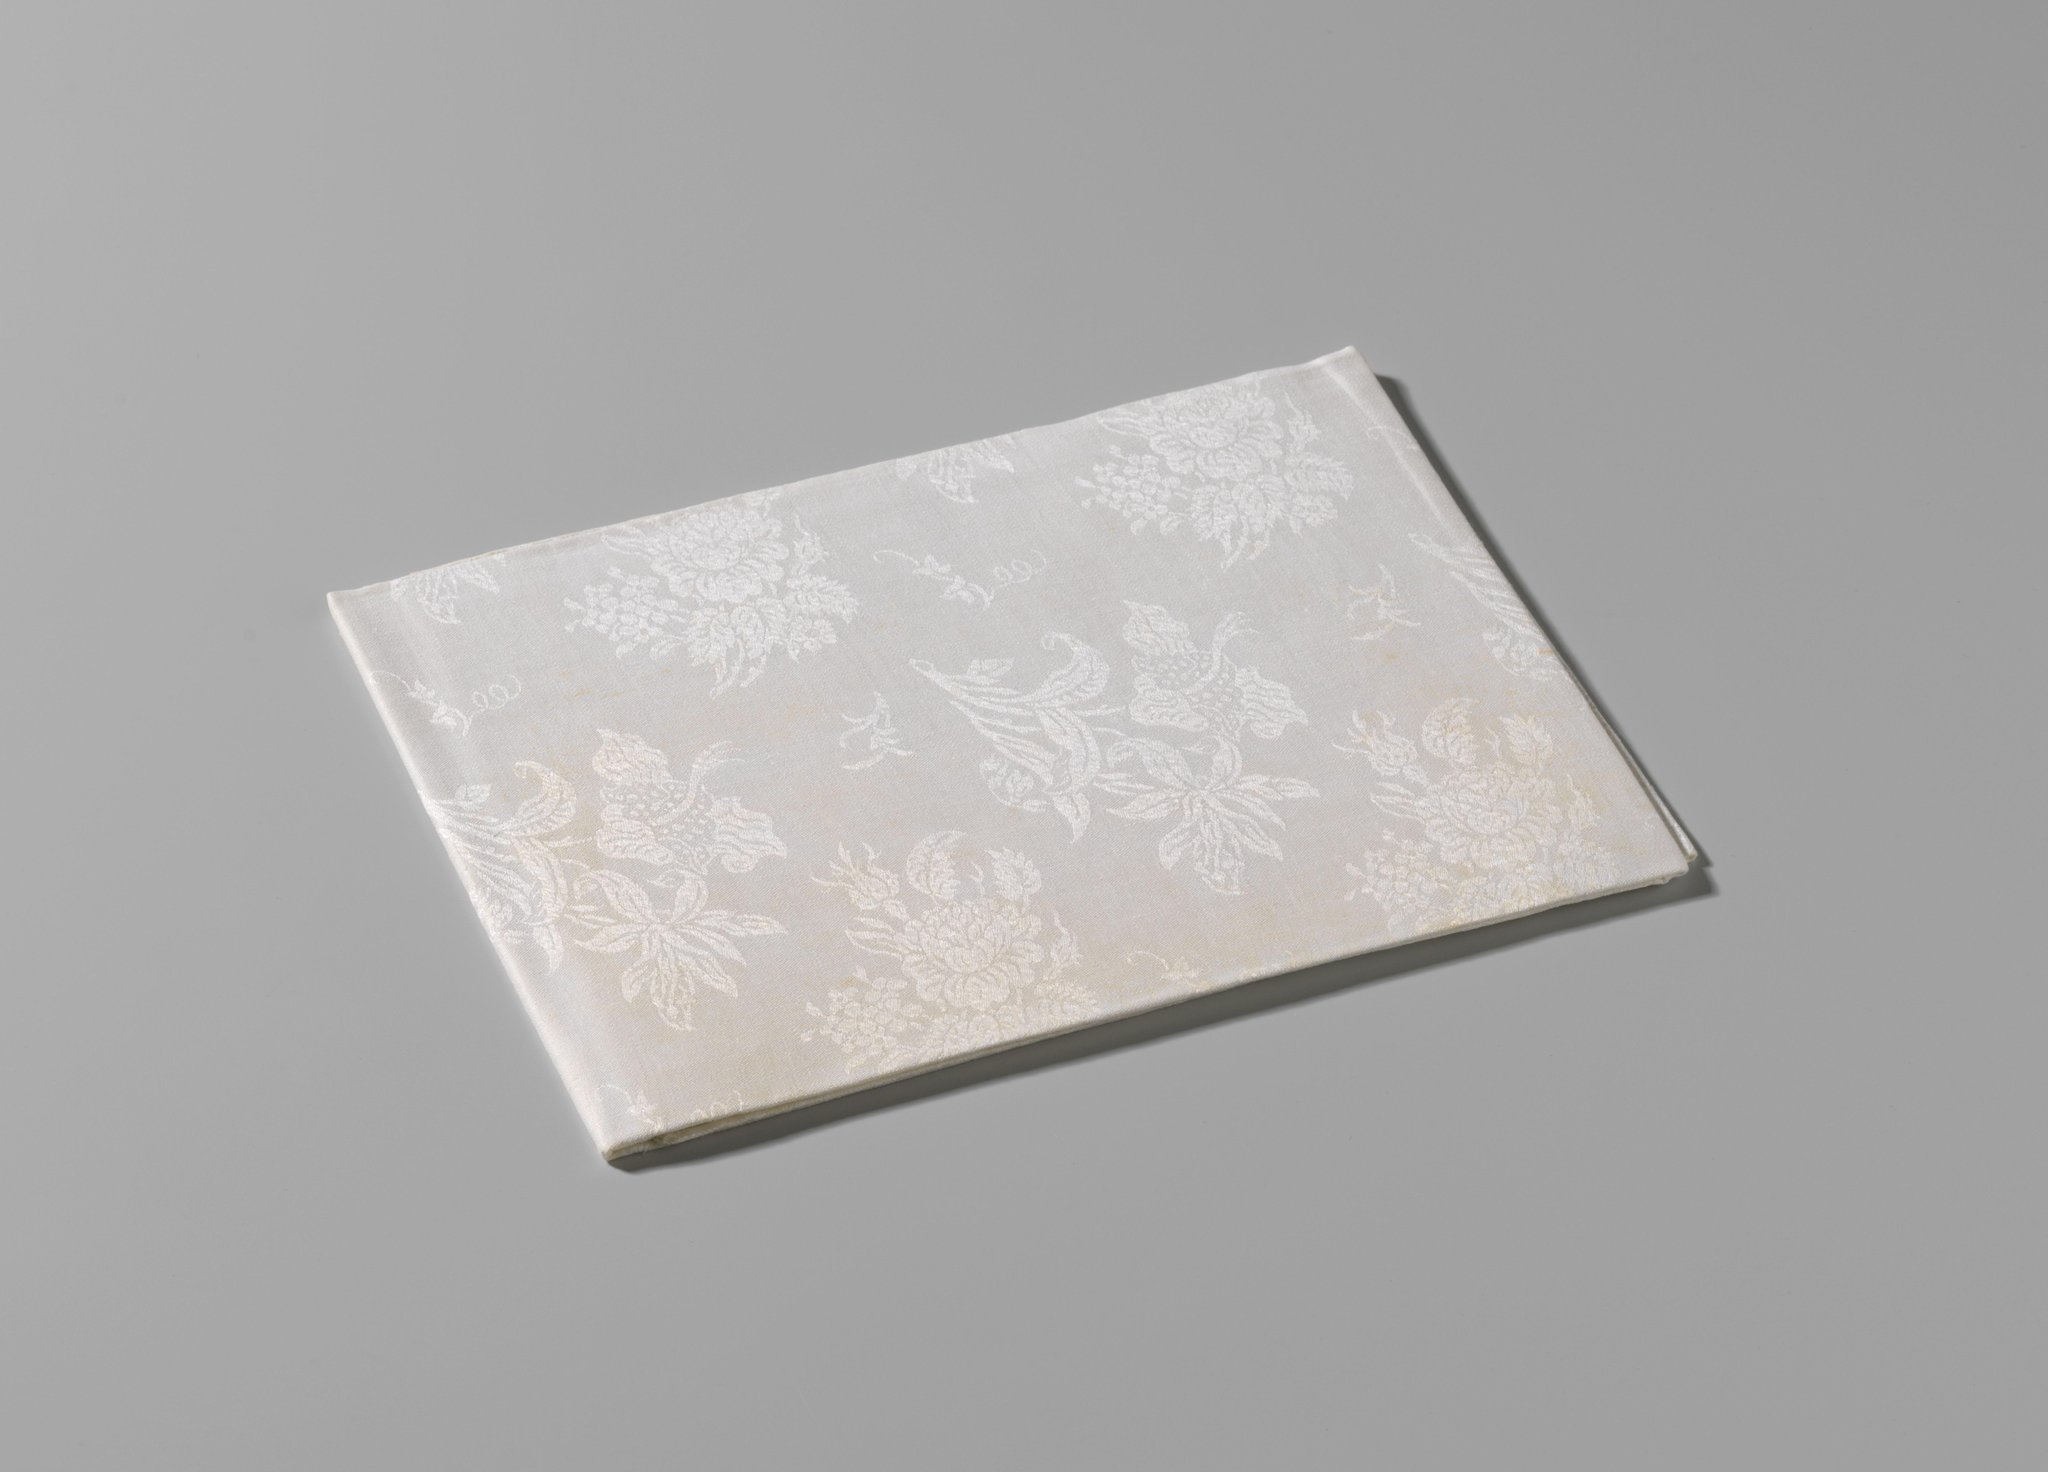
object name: napkin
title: Servet met bloemboeketten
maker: Anonymous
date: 1700-1899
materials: linen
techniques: damask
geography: saxony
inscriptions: mark: ‘GvO’, mark: ‘24’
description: Servet van linnendamast met bloemboeketten. Middenveld: Bloempatroon van verspringende rijen met twee soorten bloemboeketten. Staande en liggende randen: een bloemslinger, de hoeken een bloemboeket.